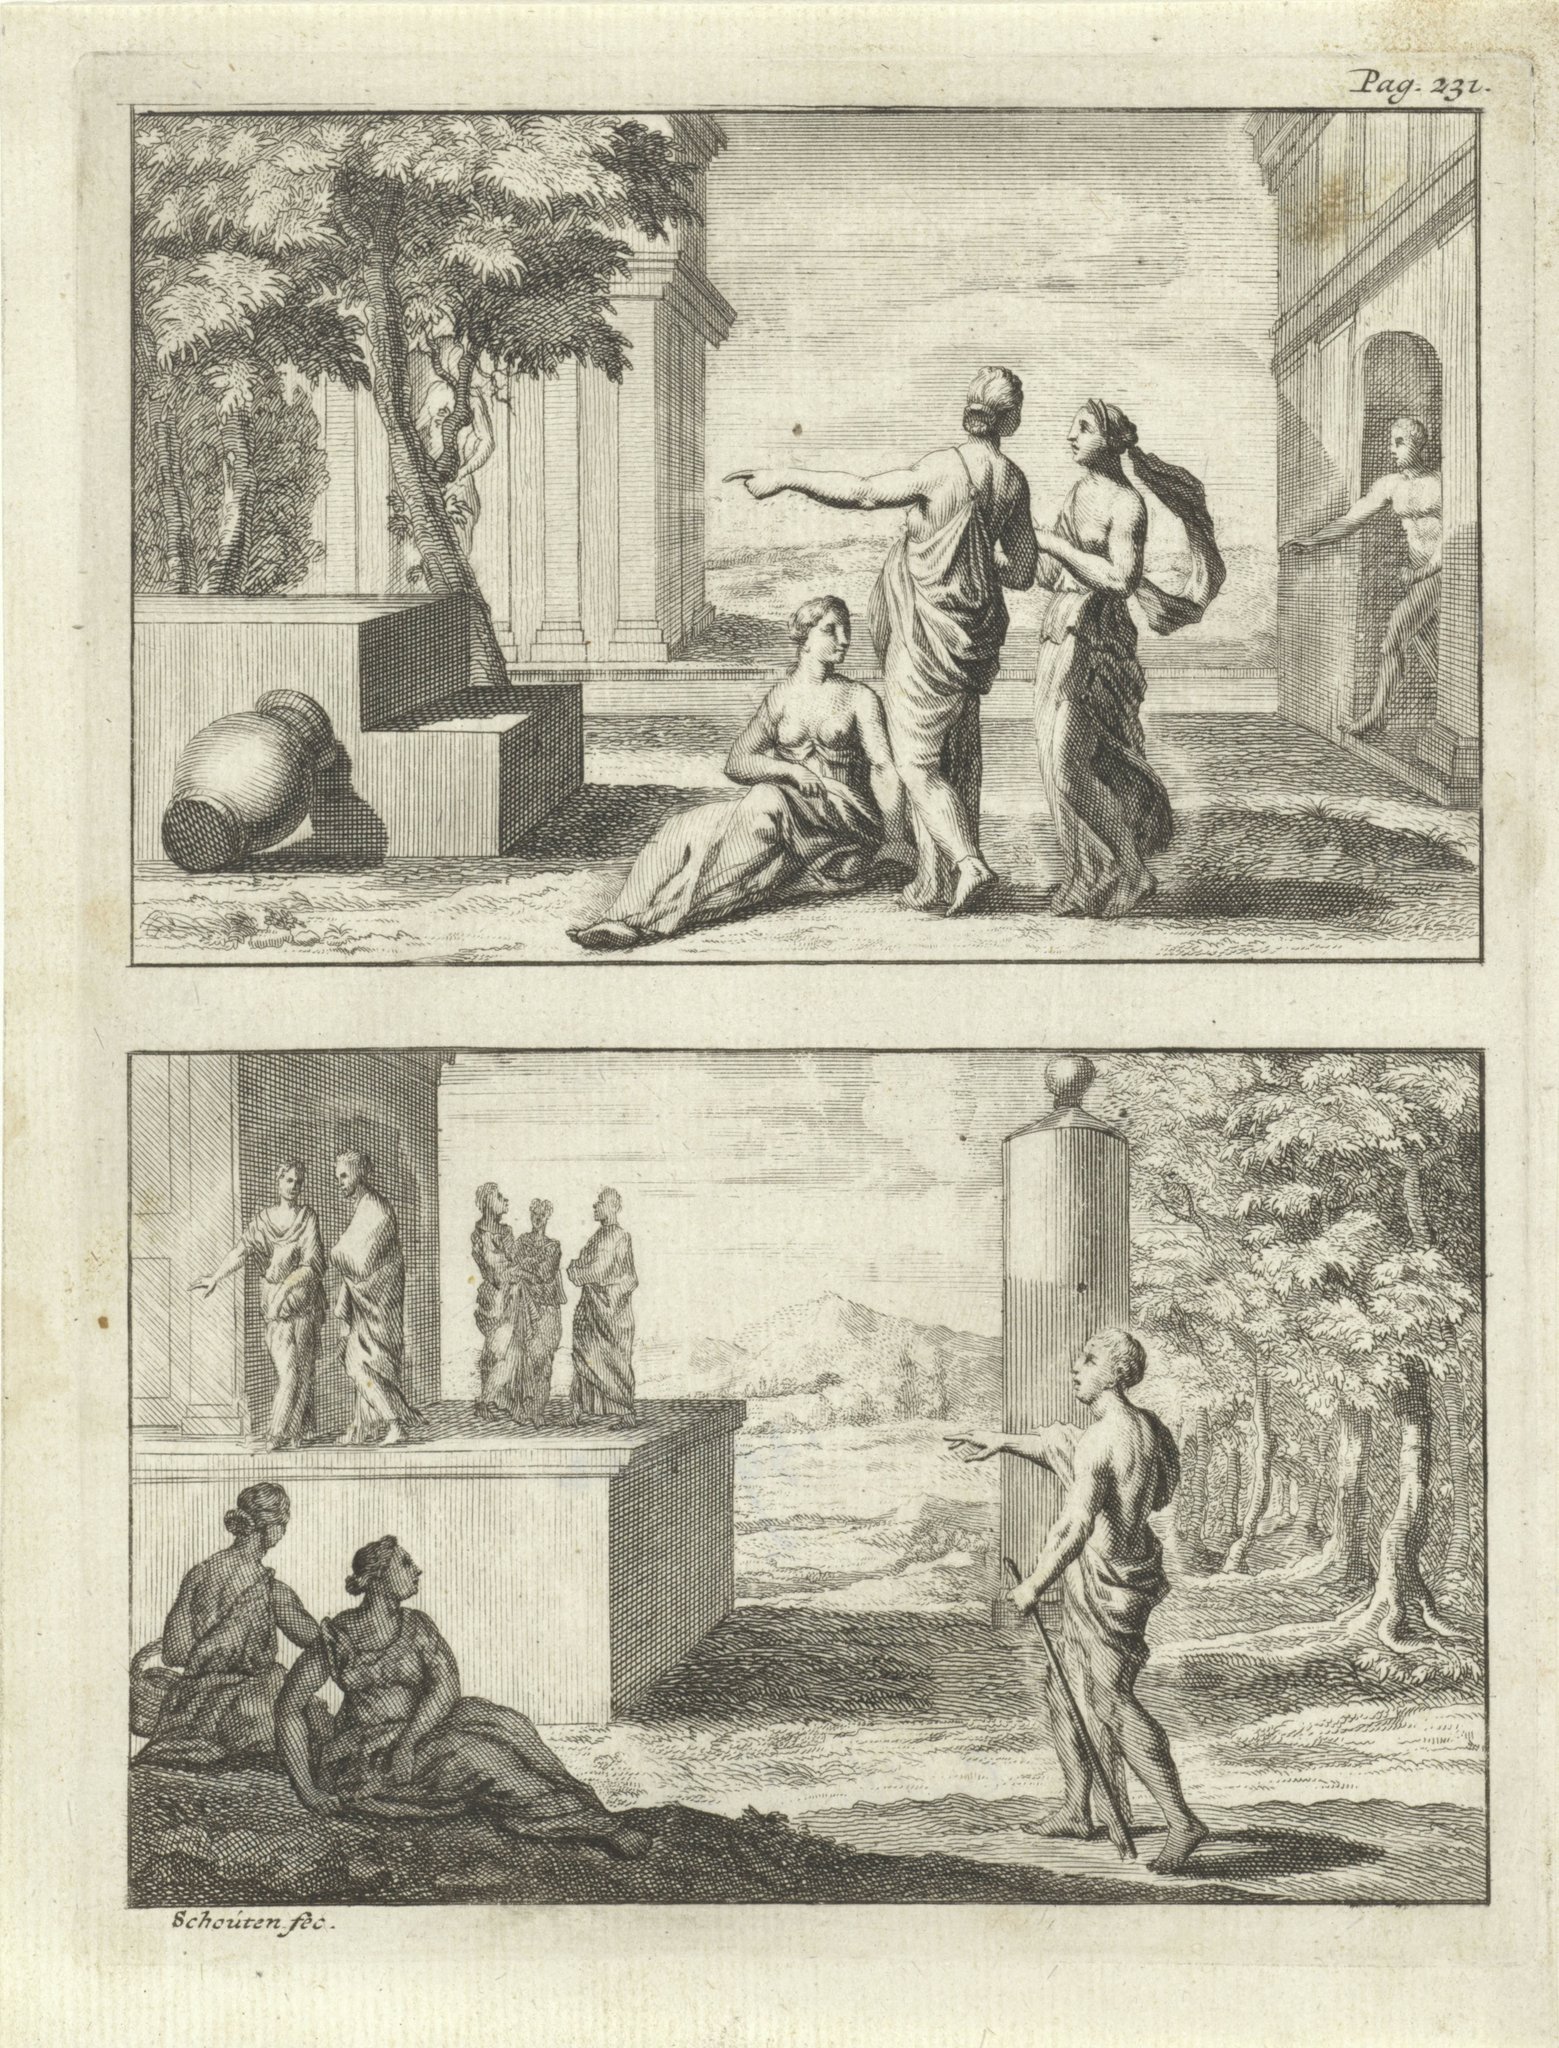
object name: book illustration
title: Illustraties met figuurcomposities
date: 1706-1722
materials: paper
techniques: engraving, etching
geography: netherlands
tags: index finger forwards, pointing, indicating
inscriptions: collector's mark: Lugt 2166, collector's mark: Lugt 2760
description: Twee illustraties boven elkaar. Boven: drie antieke vrouwenfiguren in een landschap met architectuurfragmenten. Onder: een man met staf die naar een tempel wijst. Rechtsboven: pag. 231.